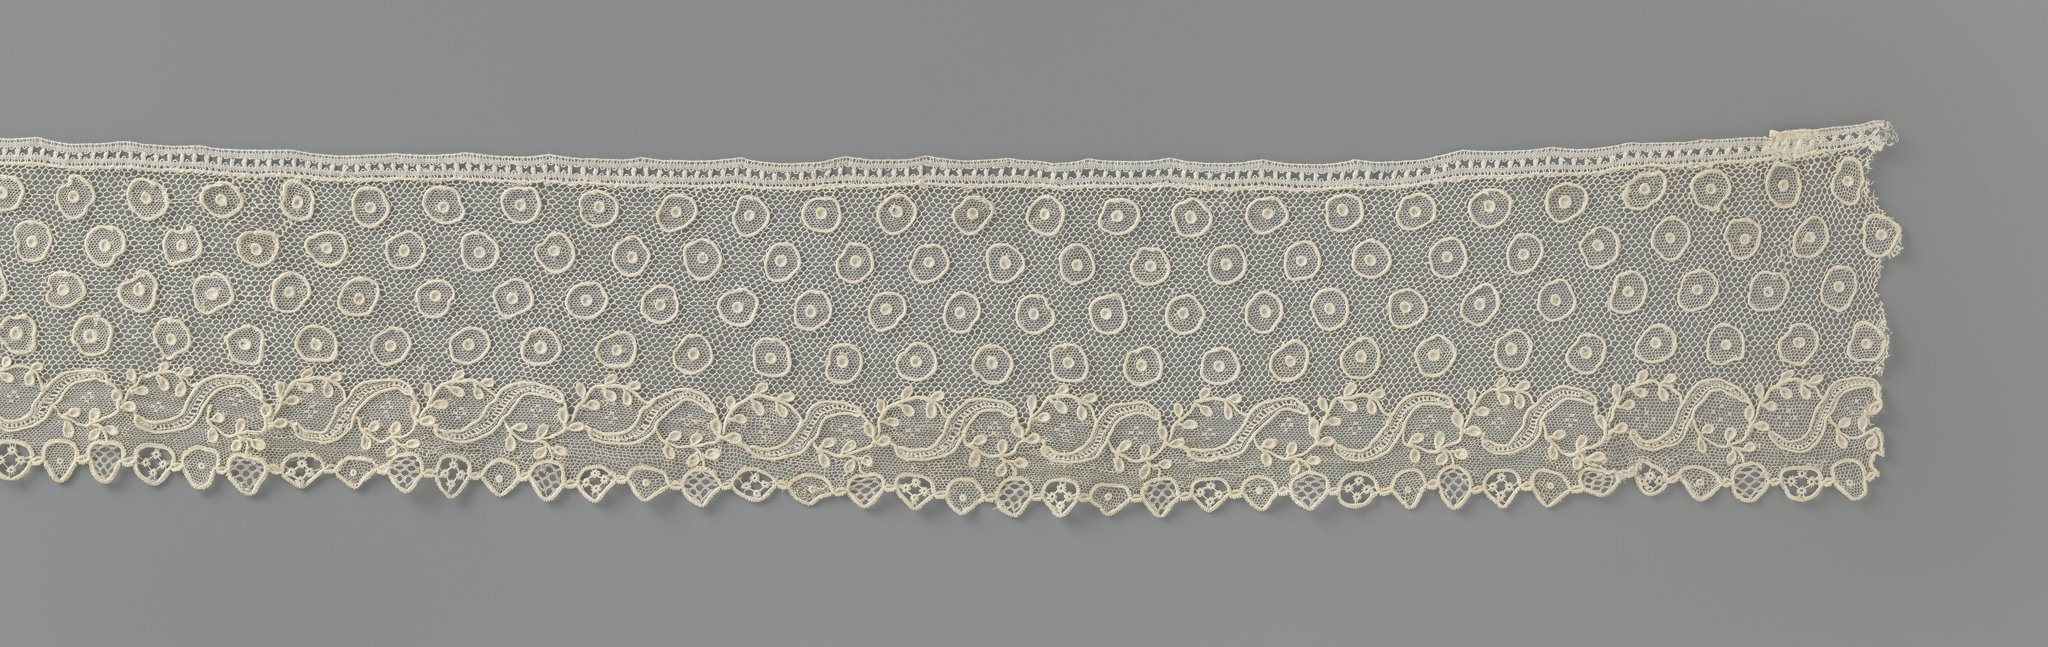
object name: strip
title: Strook naaldkant met oogjespatroon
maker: Anonymous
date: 1790-1799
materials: linen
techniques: lace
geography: france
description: Strook naturelkleurige naaldkant: Alençon-kant. Het middenveld vertoont een grove, de rand een fijne maasgrond. Het veld is gevuld met gestrooide oogjes. De overgang wordt gevormd door dubbele guirlandes, waarvan de ene bestaat uit een lint, de andere uit een rank met blaadjes. Fijne schulpjesrand van cirkeltjes met verscheidene siersteken.